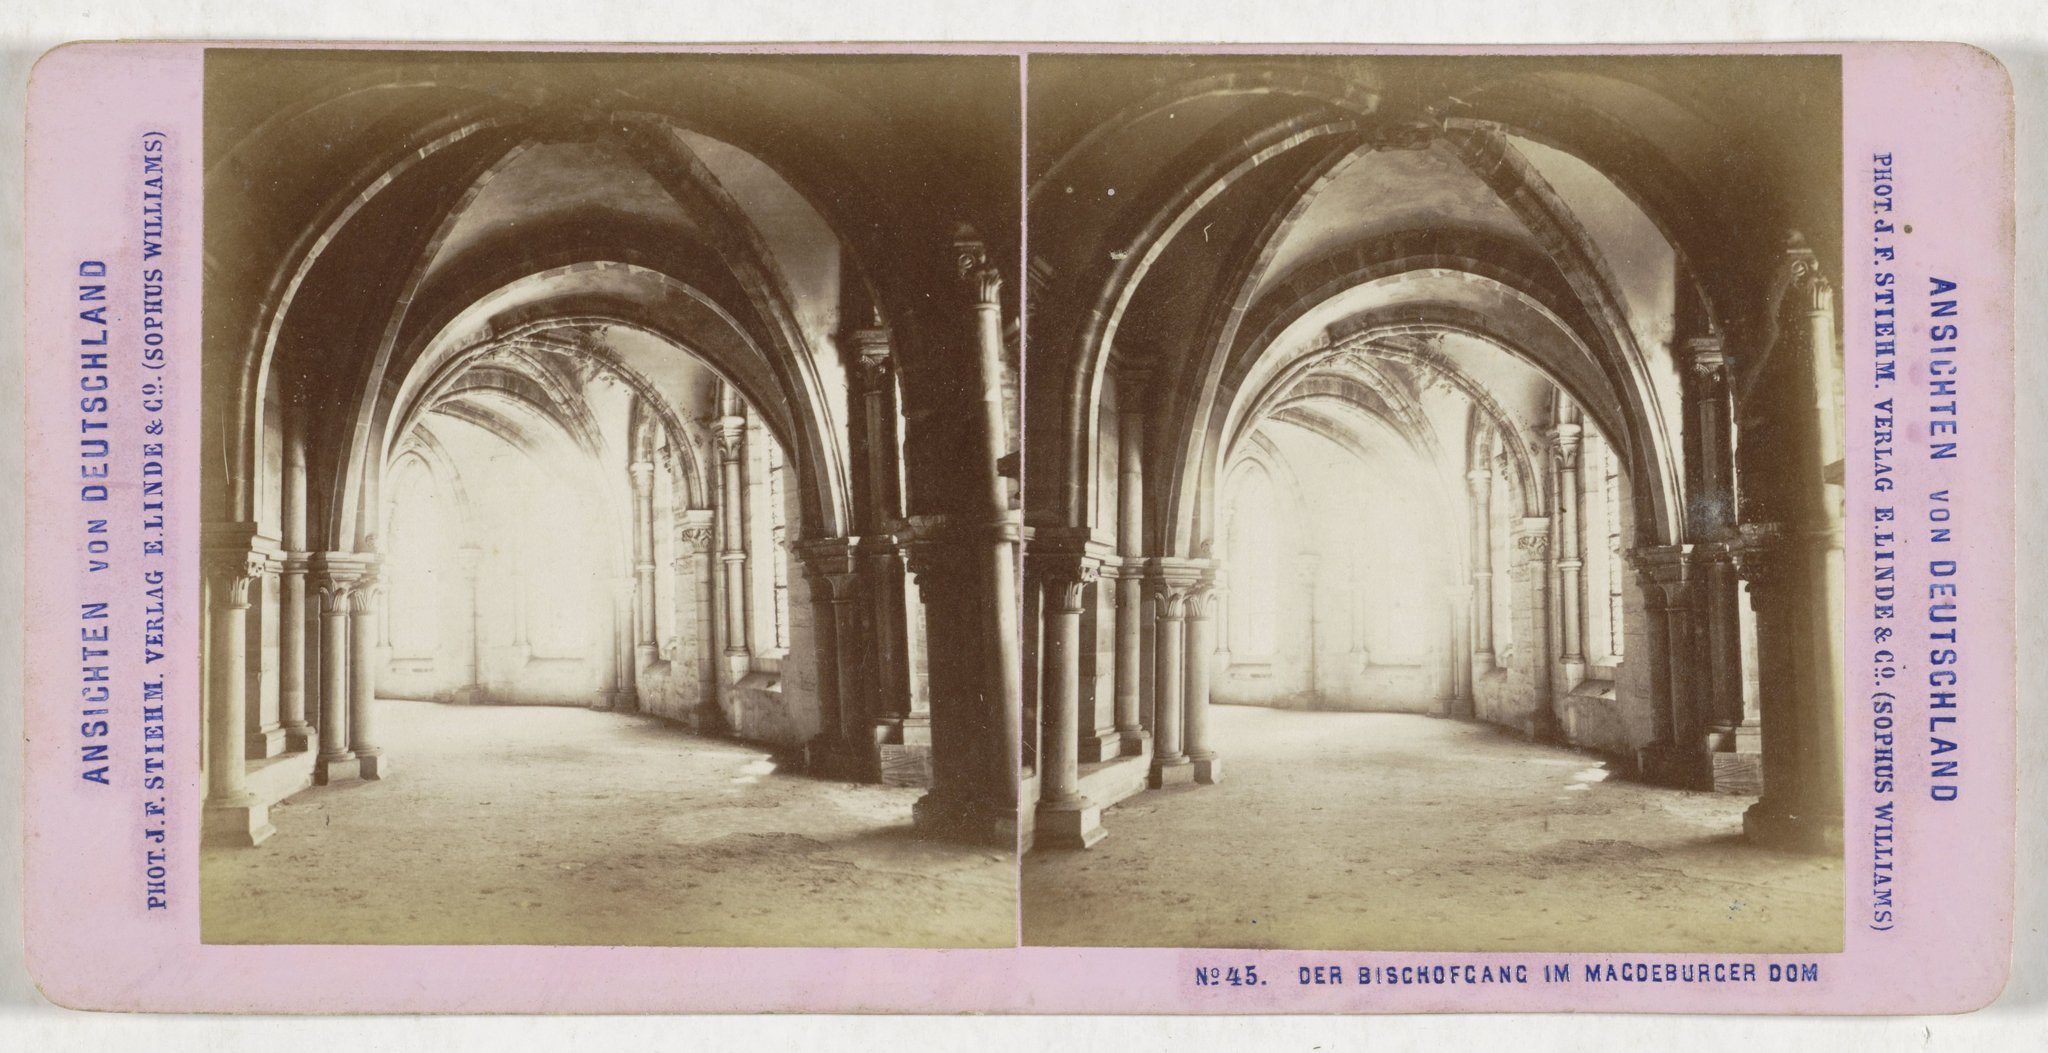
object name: stereograph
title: Kruisgang in de Dom van Maagdenburg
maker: johann friedrich stiehm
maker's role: fotograaf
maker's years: 1826-1902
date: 1869-1872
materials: cardboard, paper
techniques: albumen print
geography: berlin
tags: cloisters ~ monastery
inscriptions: number: ‘No 45.’